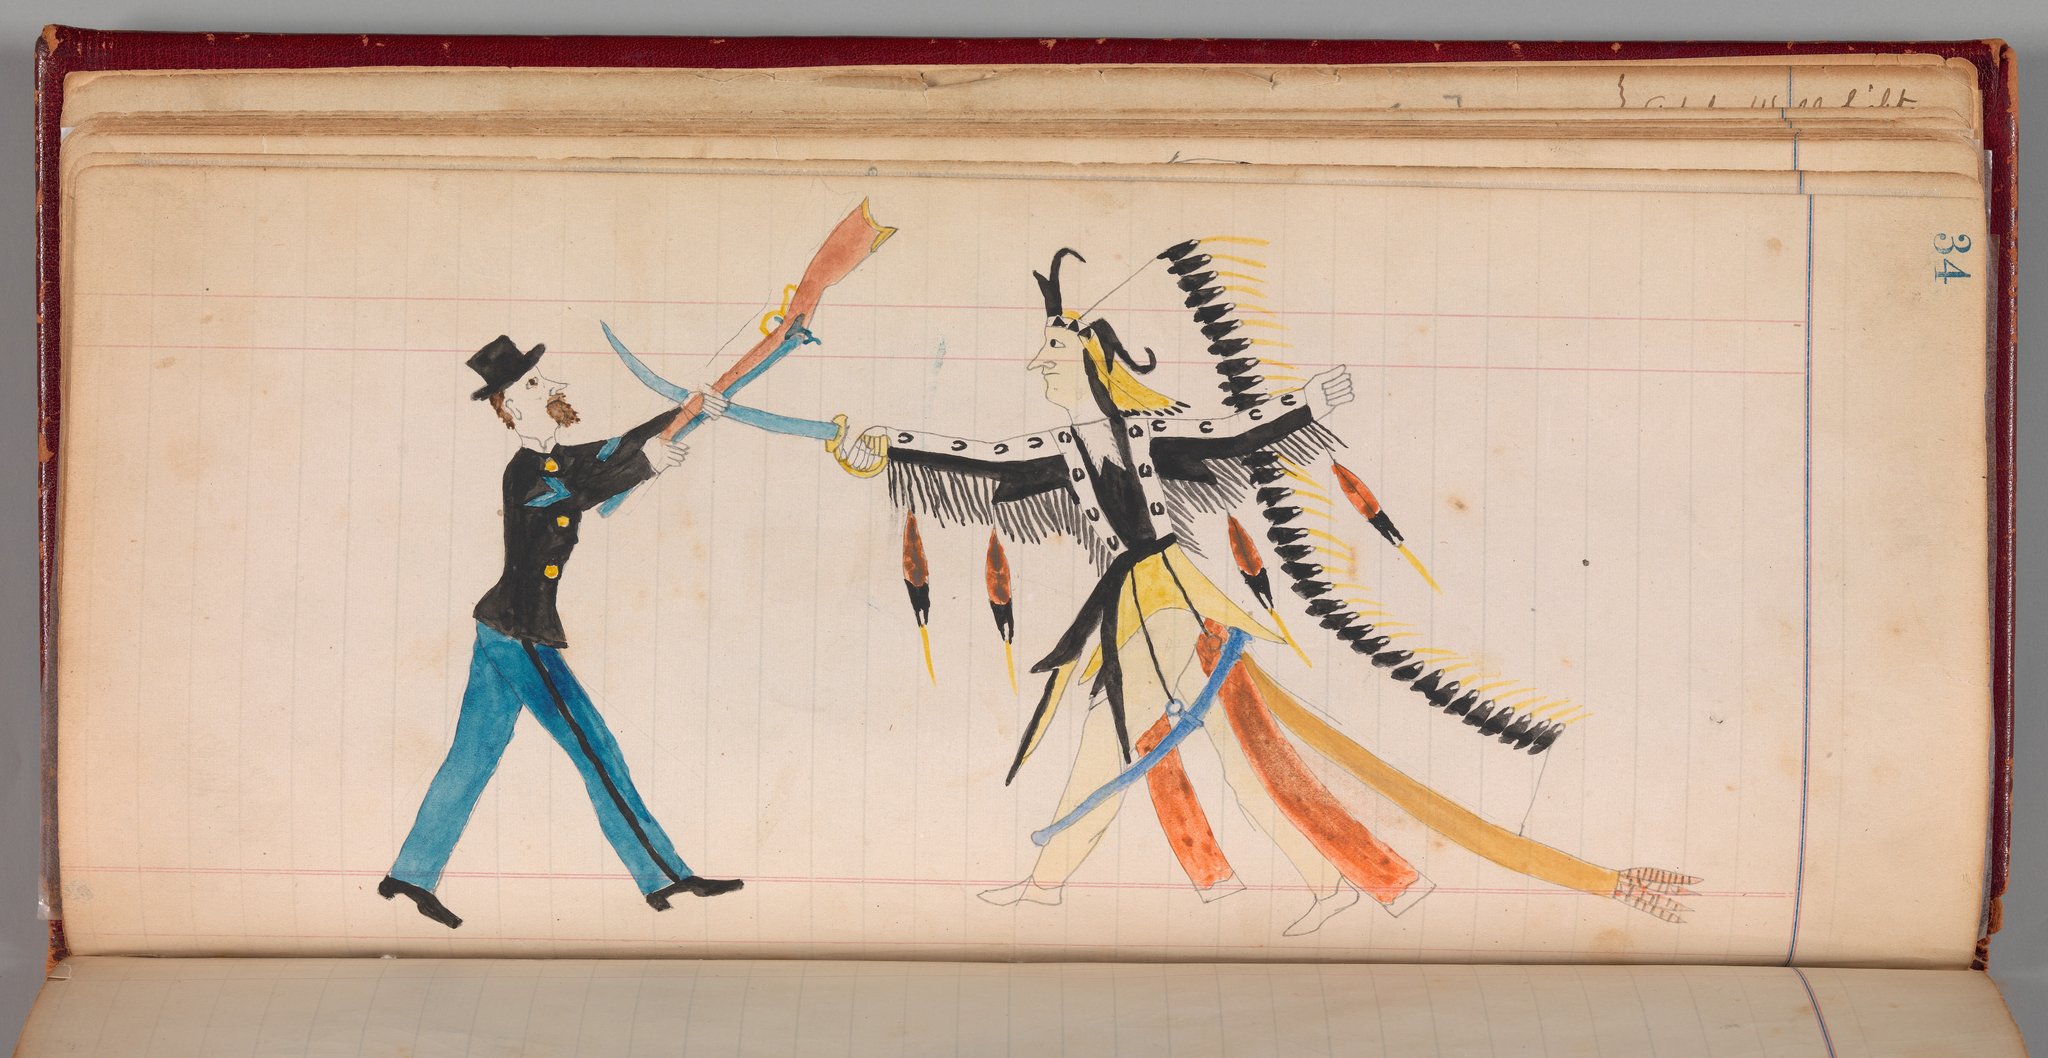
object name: drawing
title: Maffet Ledger: Indian chief and soldier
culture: cheyenne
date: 1874-1881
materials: crayon, graphite, paper, watercolor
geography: united states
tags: soldiers,firearms,men